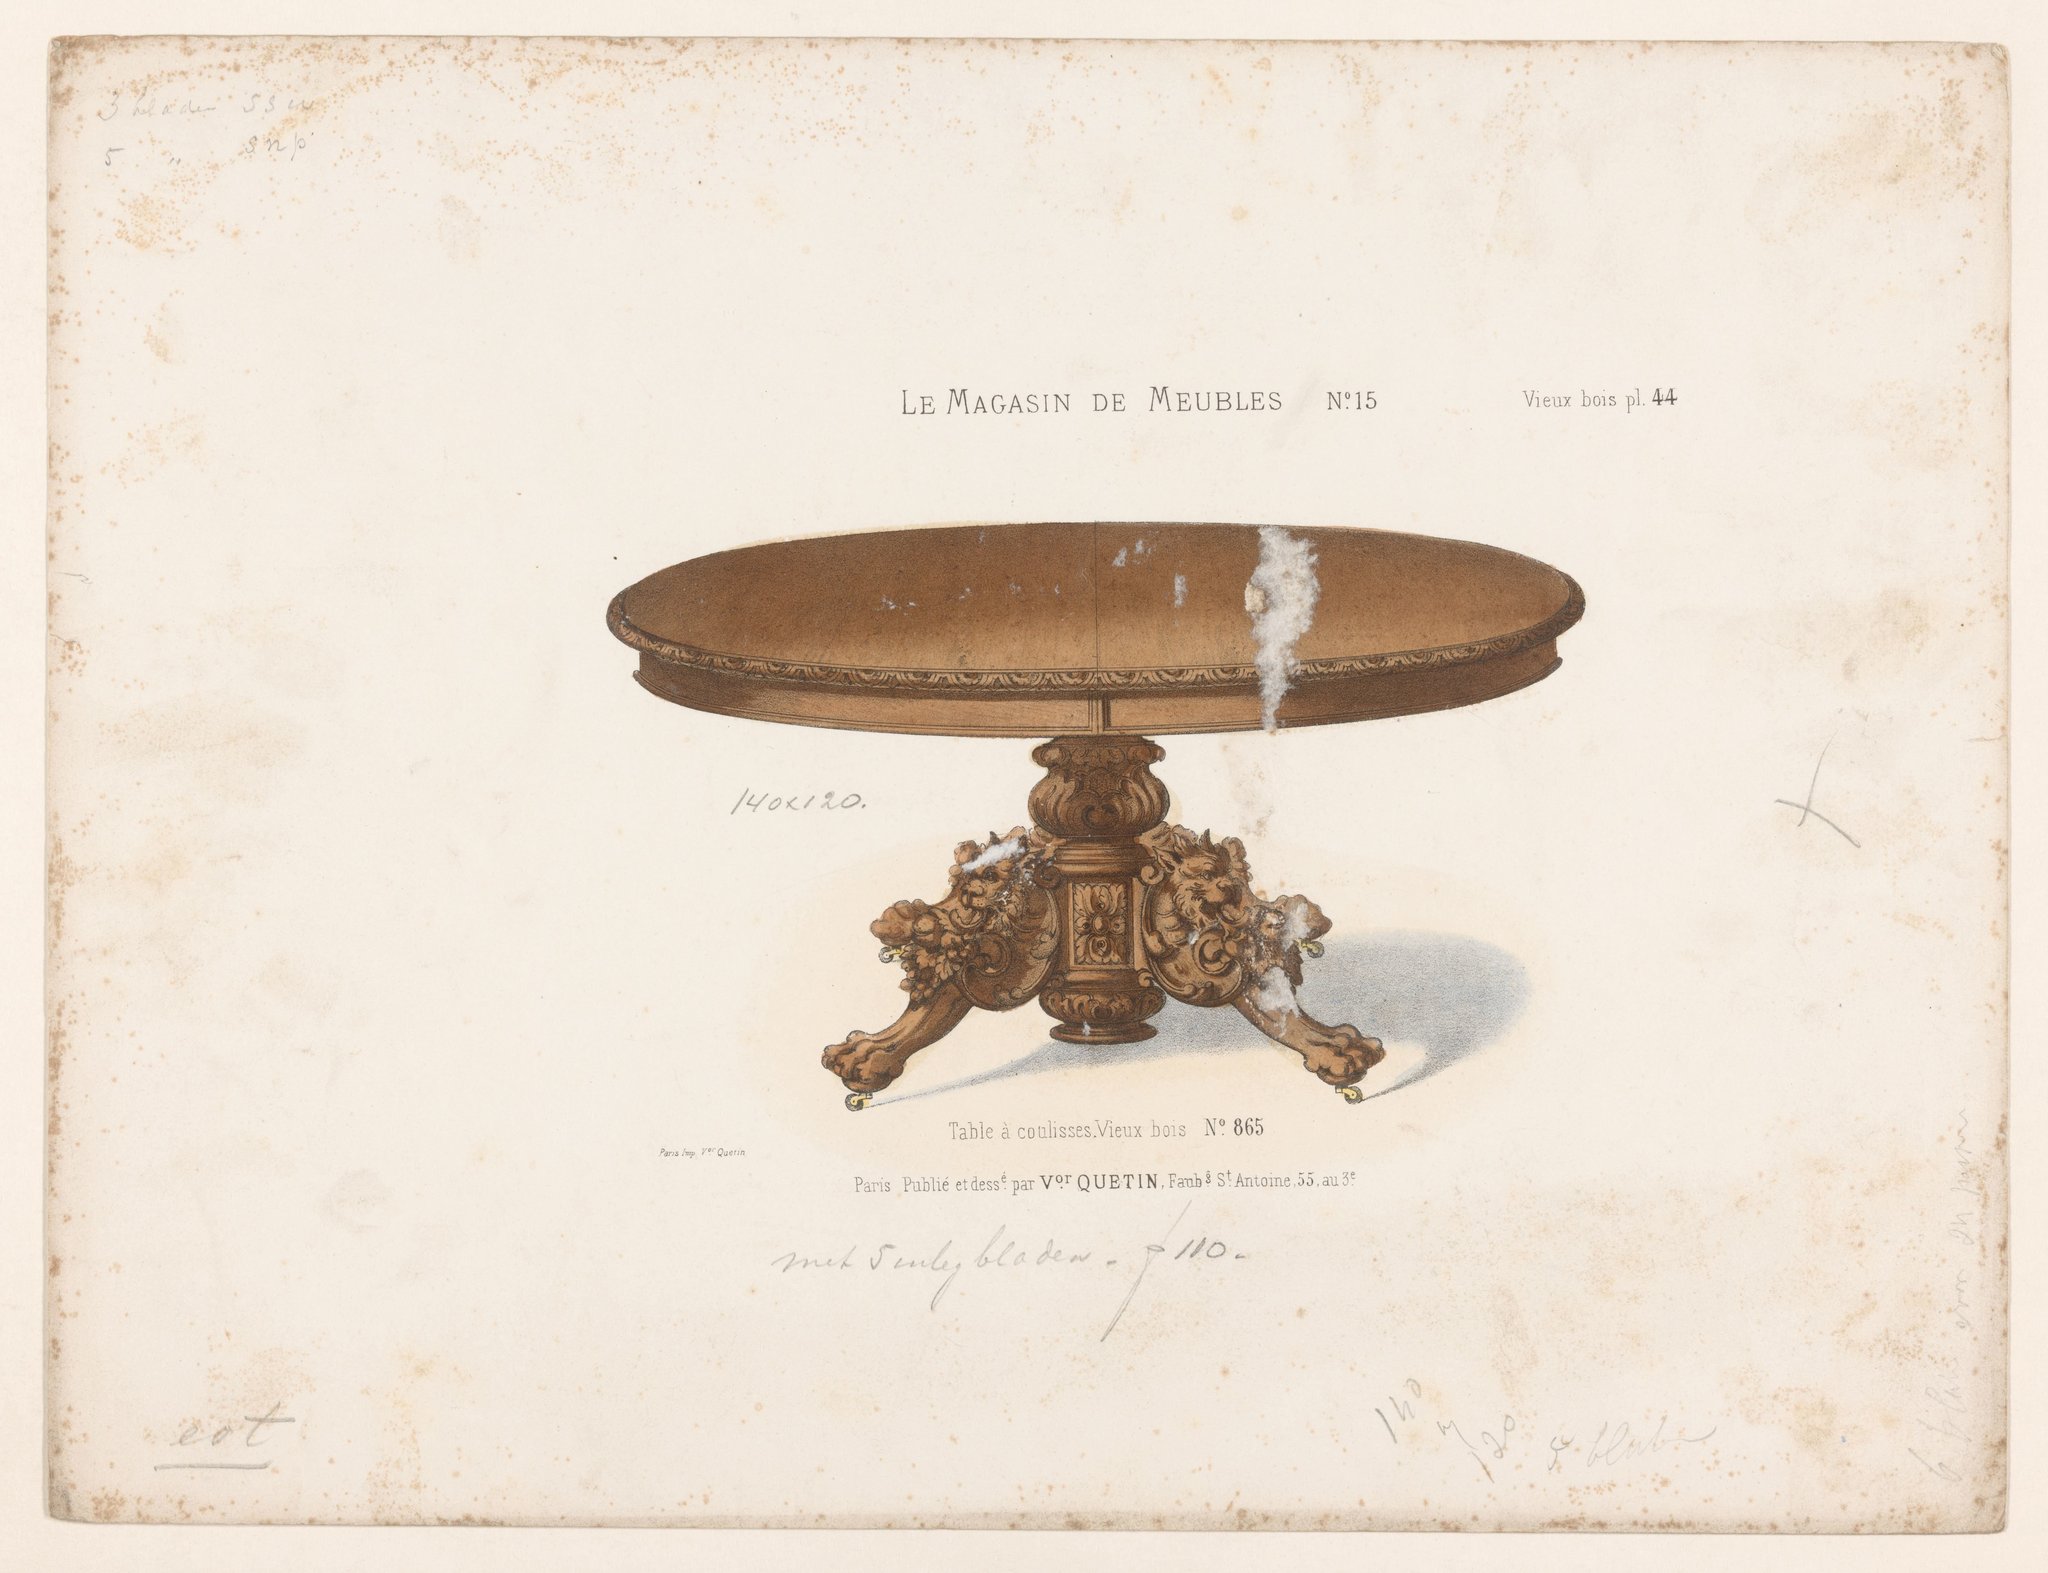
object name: print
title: Table à coulisses. Vieux bois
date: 1832-1877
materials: paper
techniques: hand coloring, lithograph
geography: paris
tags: table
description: Een ovale tafel. Rechts boven vermeld Vieaux bois pl. 44.